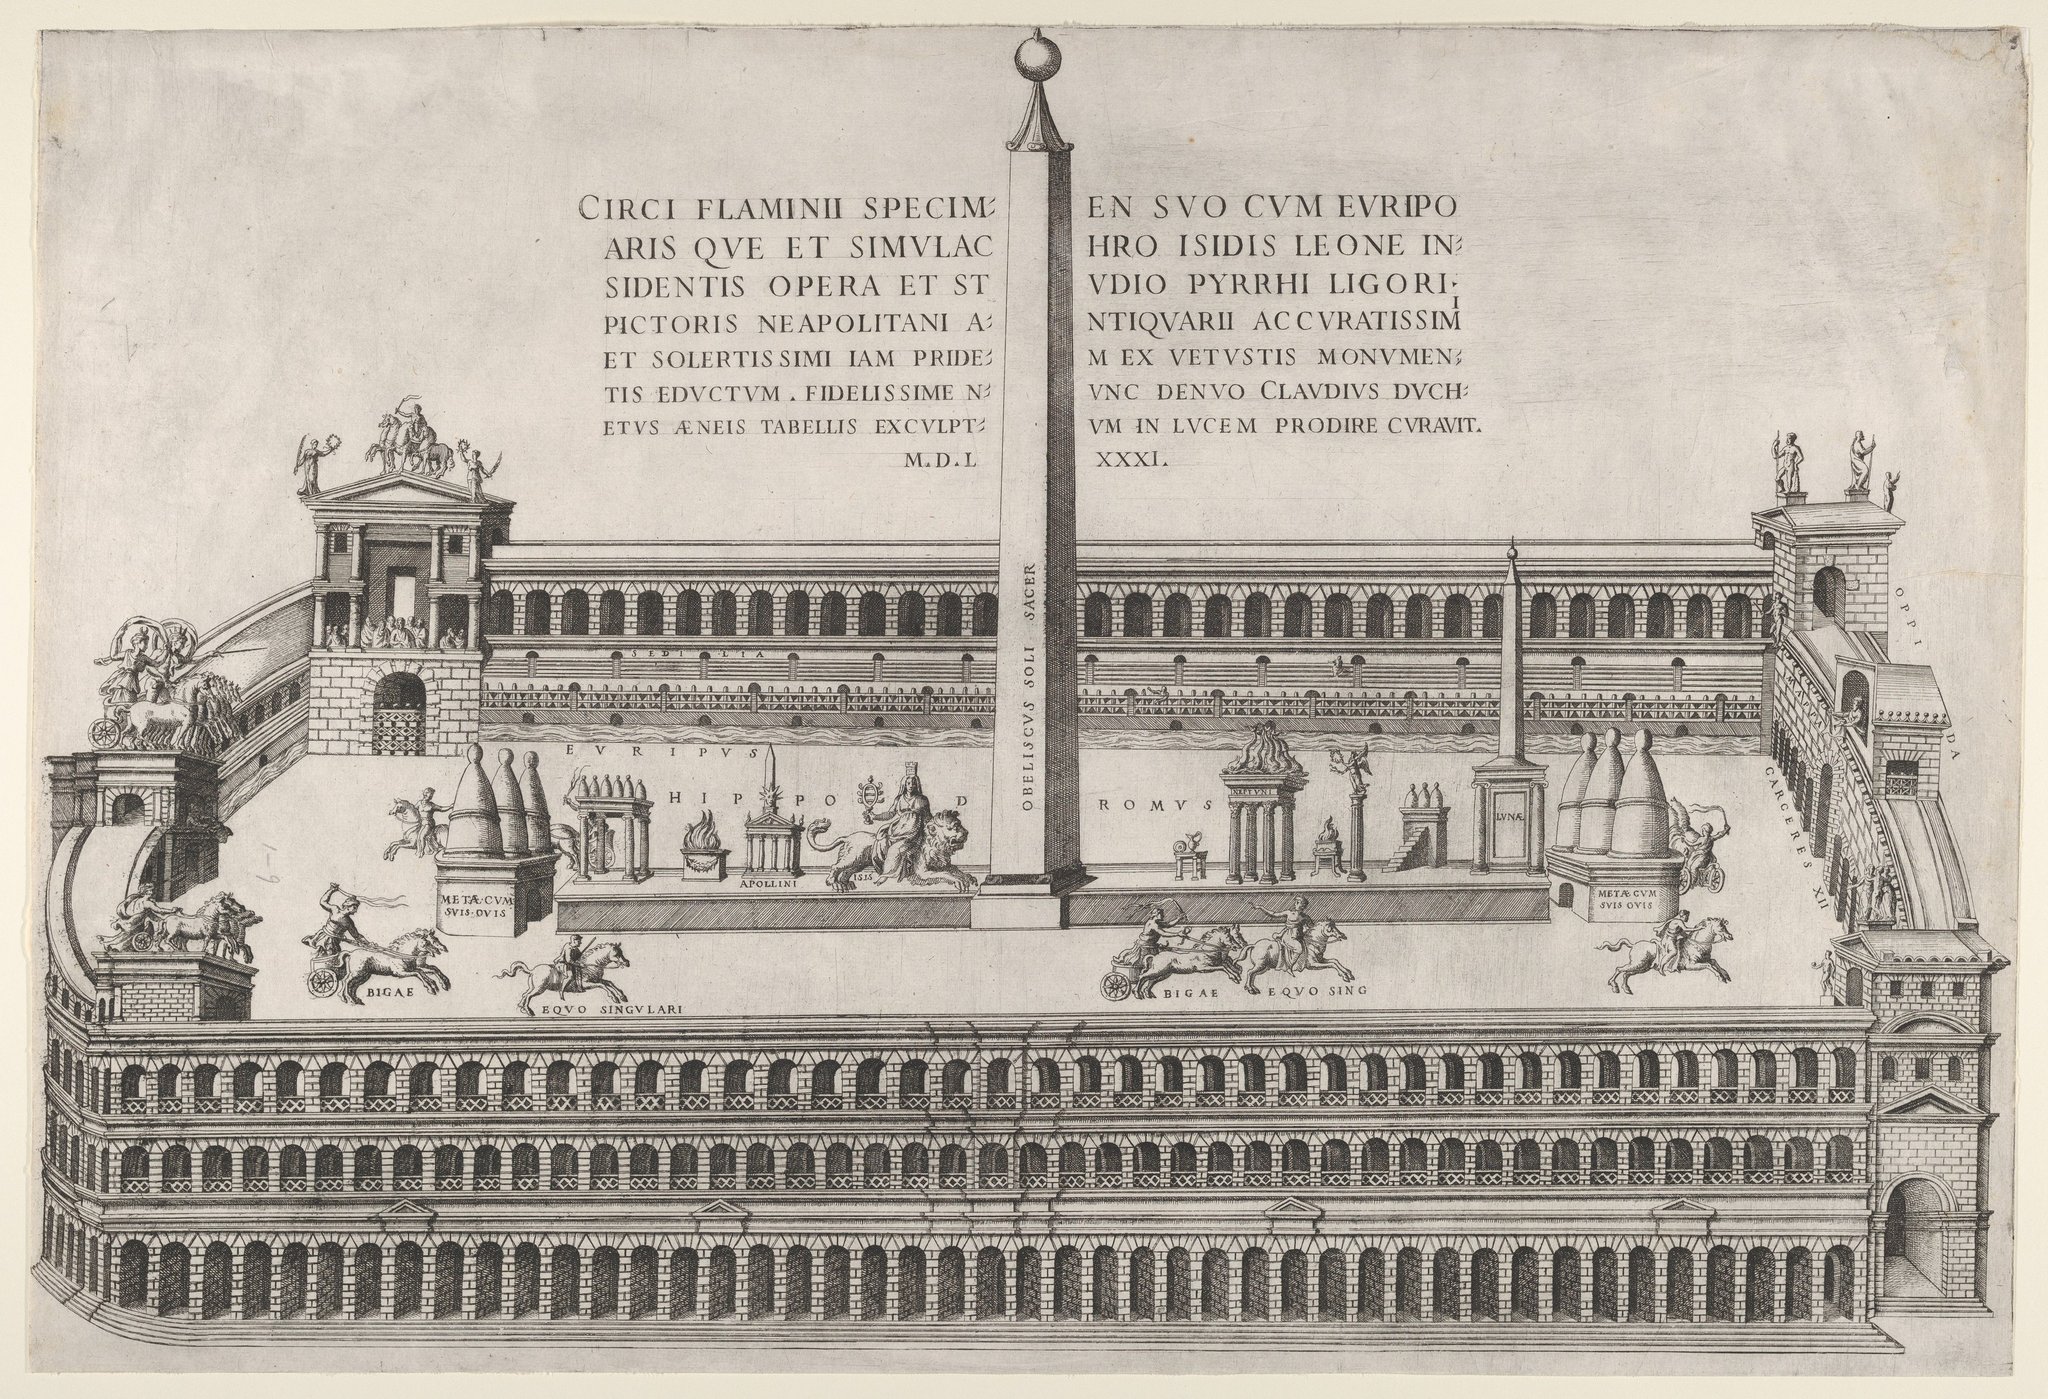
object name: print ornament architecture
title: Circus Flaminius in Rome, from "Speculum Romanae Magnificentiae"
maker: Anonymous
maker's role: artist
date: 1581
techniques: engraving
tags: obelisks,circus,horses,rome